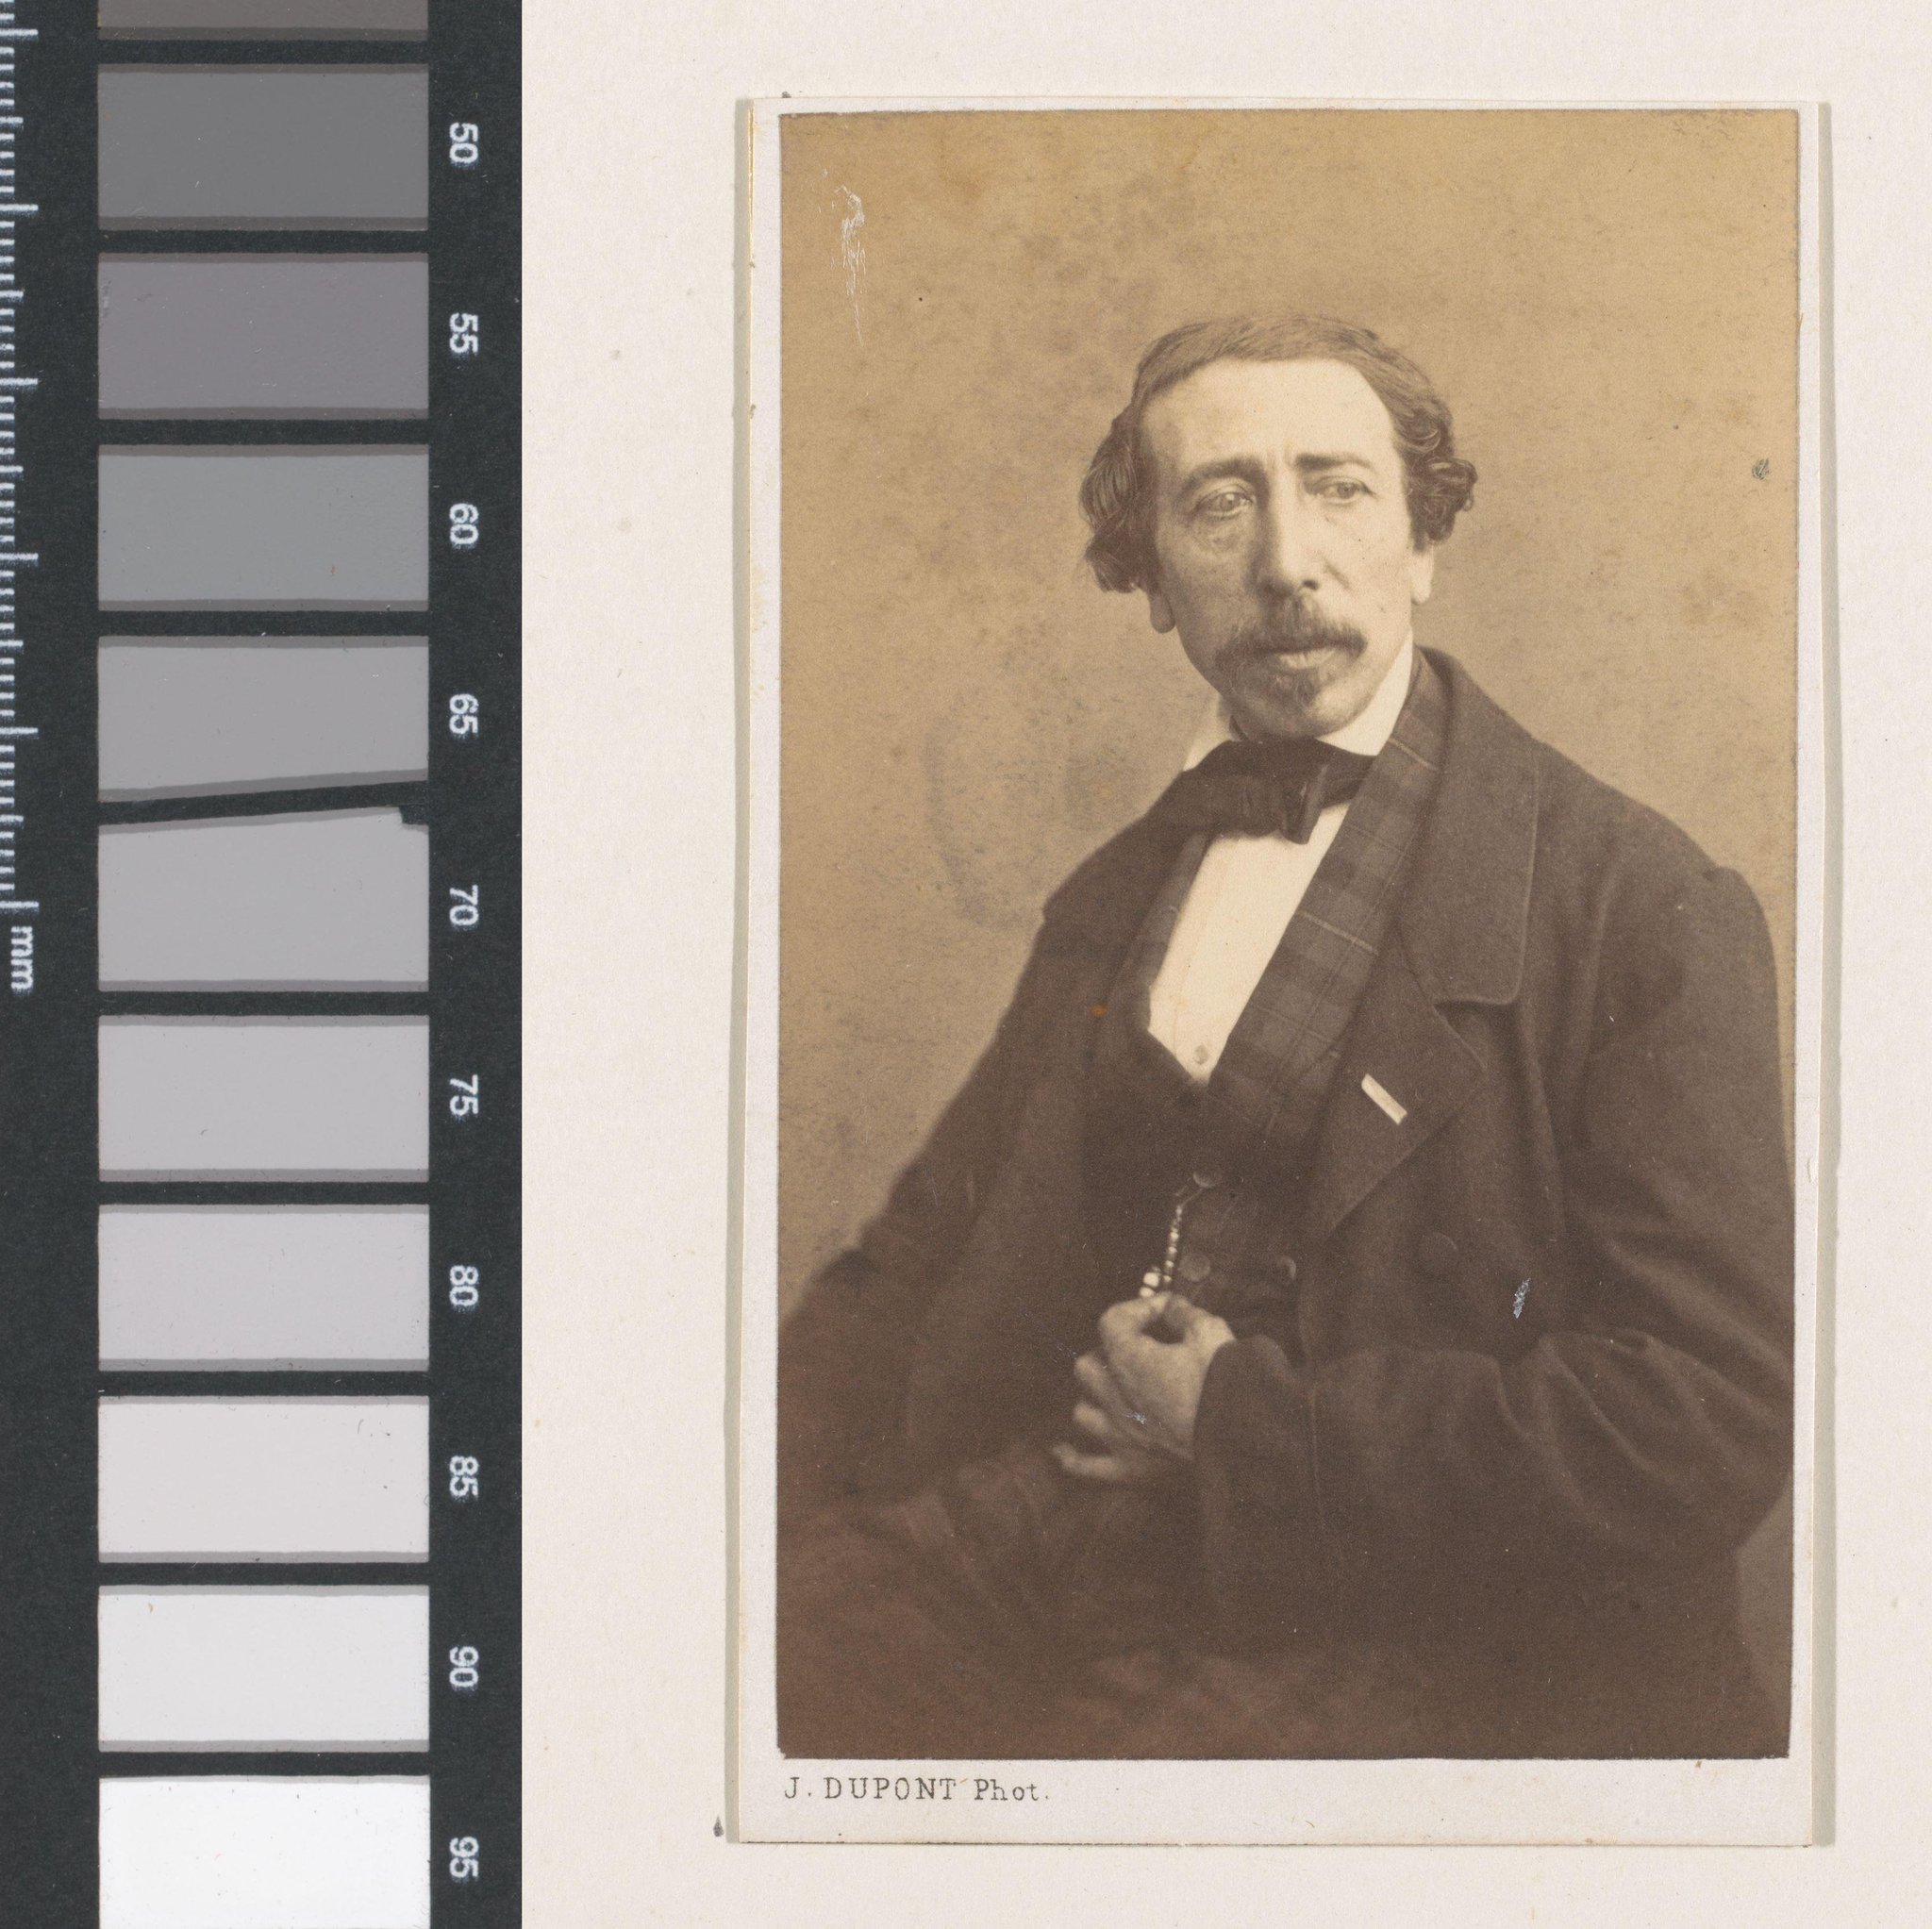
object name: photograph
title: Portret van de schilder Jacob Jacobs, halffiguur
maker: joseph dupont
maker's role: fotograaf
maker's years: 1818-1901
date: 1861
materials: cardboard, paper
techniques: albumen print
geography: antwerp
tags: antwerp, draughtsman, jacob jacobs, historical persons, portrait, self-portrait of painter, portrait, self-portrait of artist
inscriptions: inscription: ‘ETABLISSEMENT PHOTOGRAPHIQUE/ de/ J. DUPONT/ Place de Meir 32/ ANVERS/ Maison fondée en 1853’